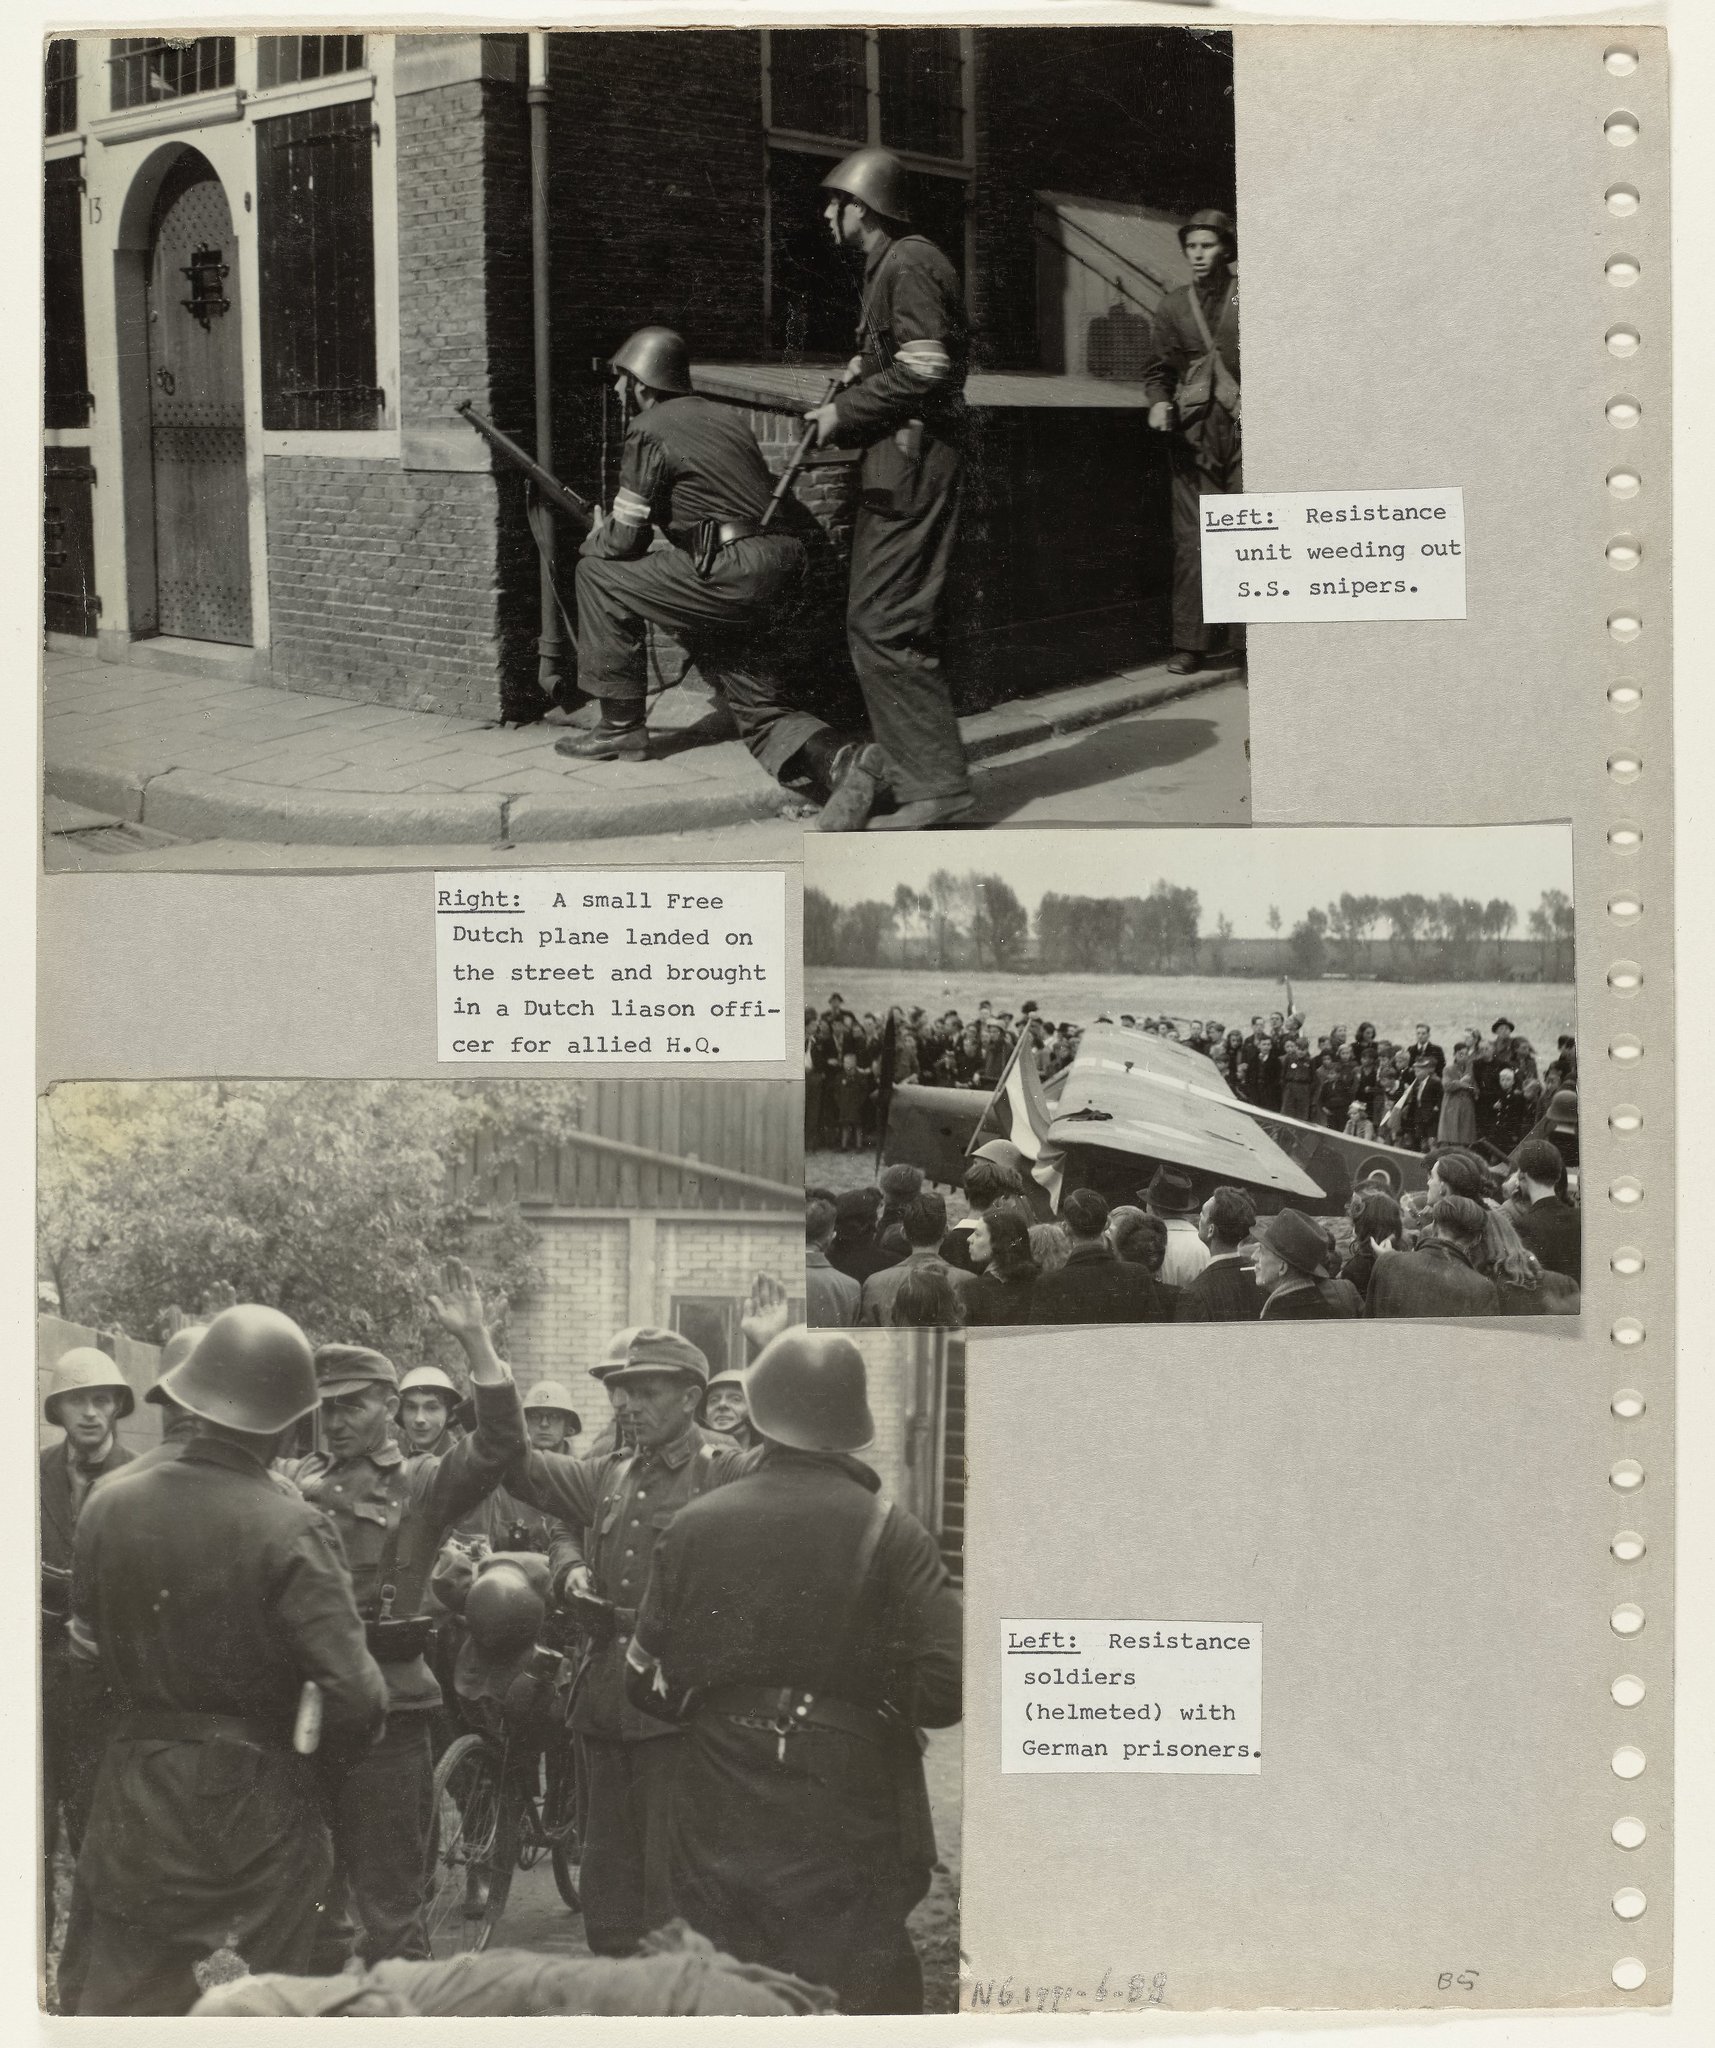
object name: photograph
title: Arrestatie Duitsers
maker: Anonymous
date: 1905-1945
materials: paper, plastic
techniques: photography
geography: netherlands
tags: amsterdam, tonny van renterghem, berlin, fritz kahlenberg, underground movement, partisans, netherlands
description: Drie foto's over de periode rond de bevrijding. Foto boven: een verzetsgroep tracht SS sluipschutters uit te schakelen. Foto midden: een klein Nederlands vliegtuig is geland met een Nederlandse verbindingsofficier aan boord. Foto onder: Leden van de BS arresteren Duitse soldaten.